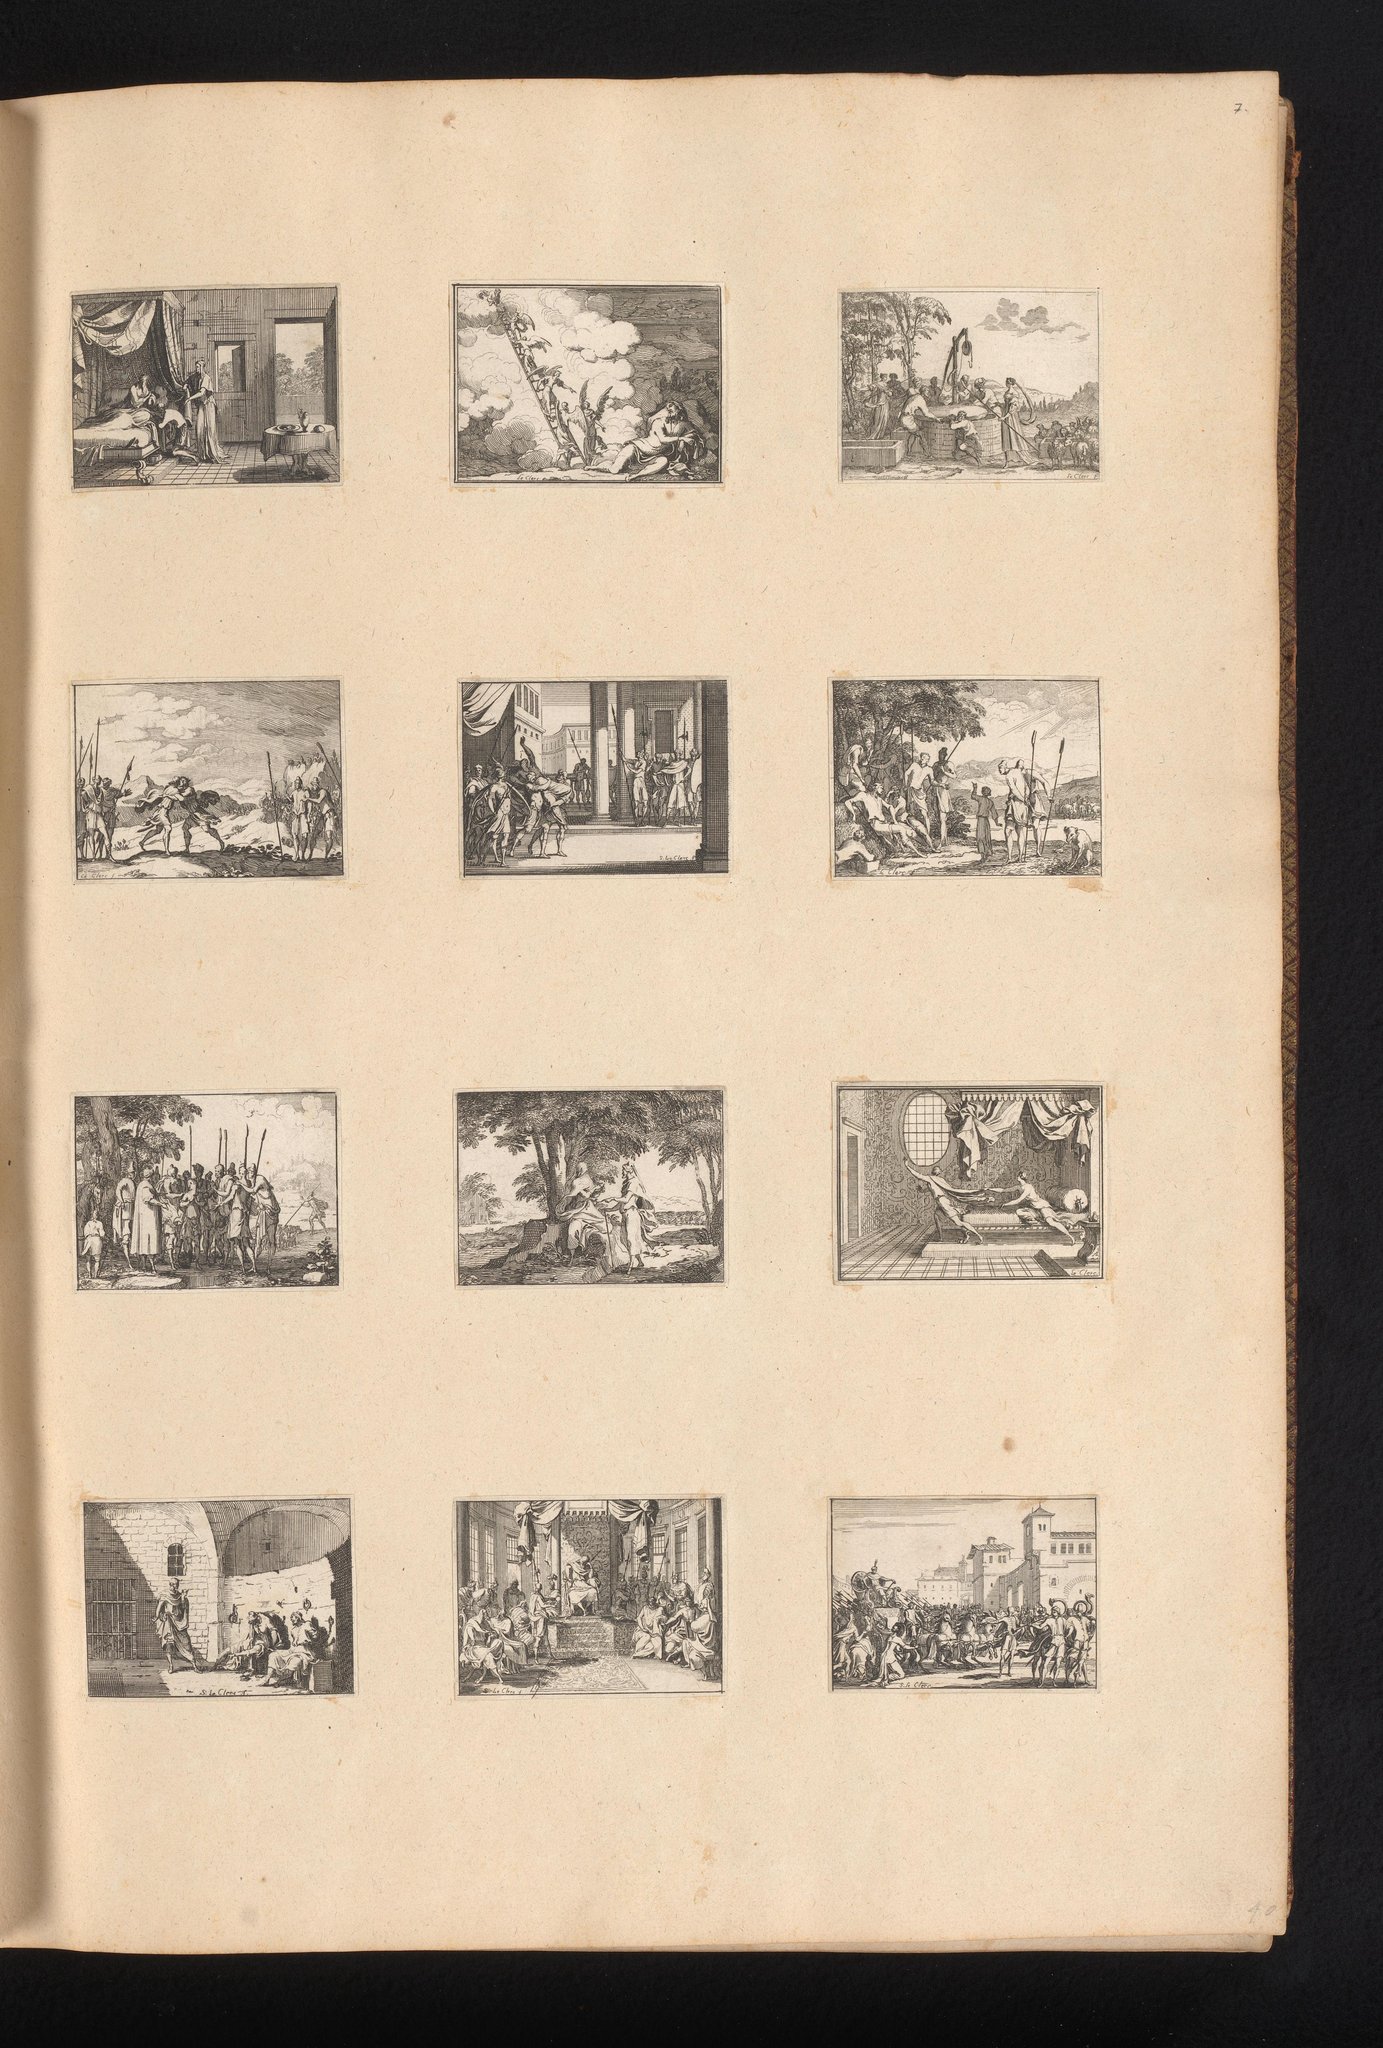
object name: album leaf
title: Oudtestamentische voorstellingen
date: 1670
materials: paper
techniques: etching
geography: paris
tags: genesis: the patriarchs, genesis: the story of joseph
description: Prenten gebruikt voor het eerste deel van: Brianville, Finé de. Histoire sacrée en tableaux (...). Parijs: Charles de Sercy, 1670. In dit boek staan verschillende oudtestamentische voorstellingen en figuren van Adam tot Samuël.